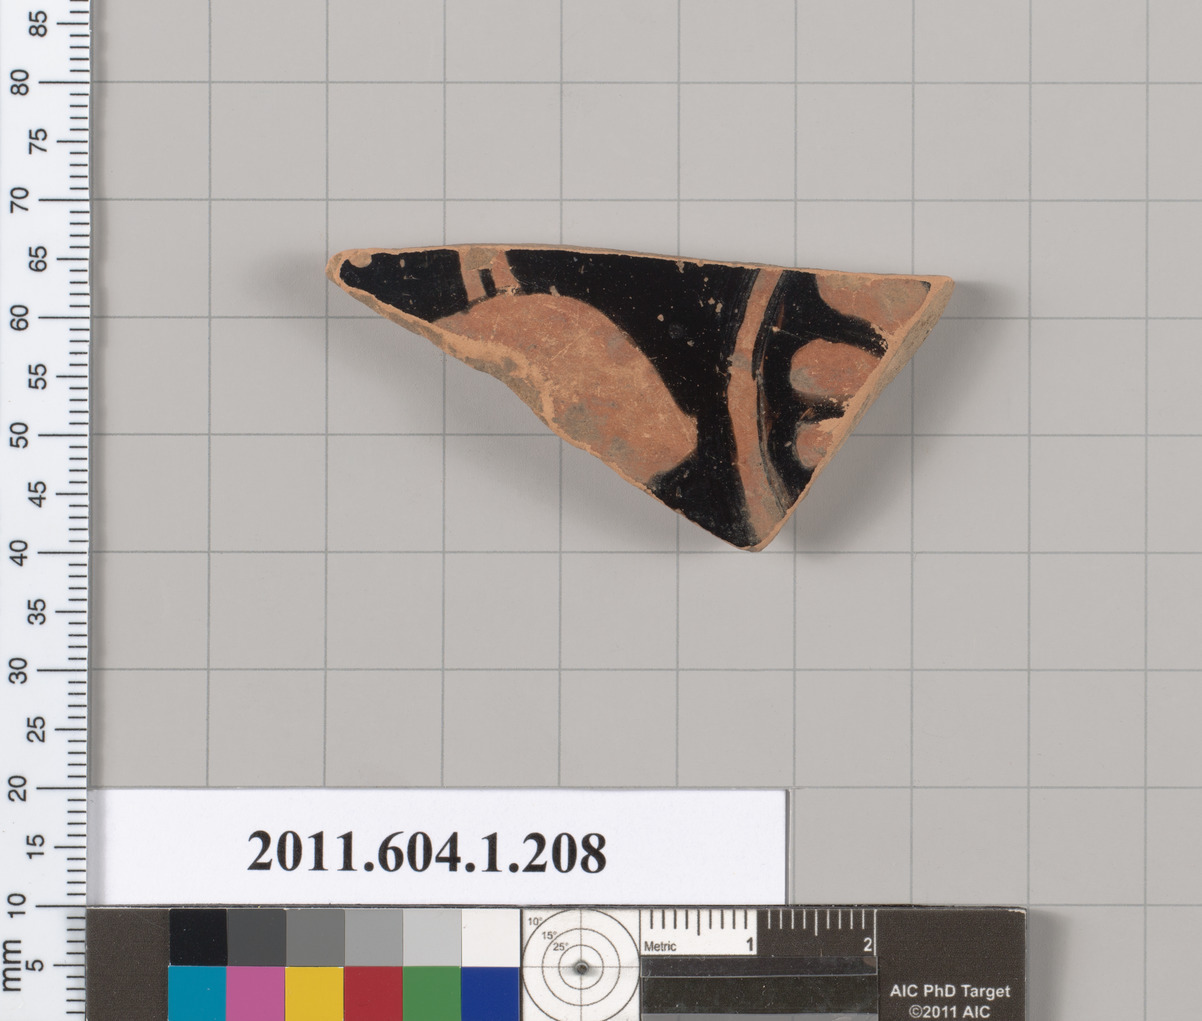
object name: kylix fragment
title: Terracotta fragment of a kylix (drinking cup)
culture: greek, attic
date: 475-451 BCE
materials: terracotta